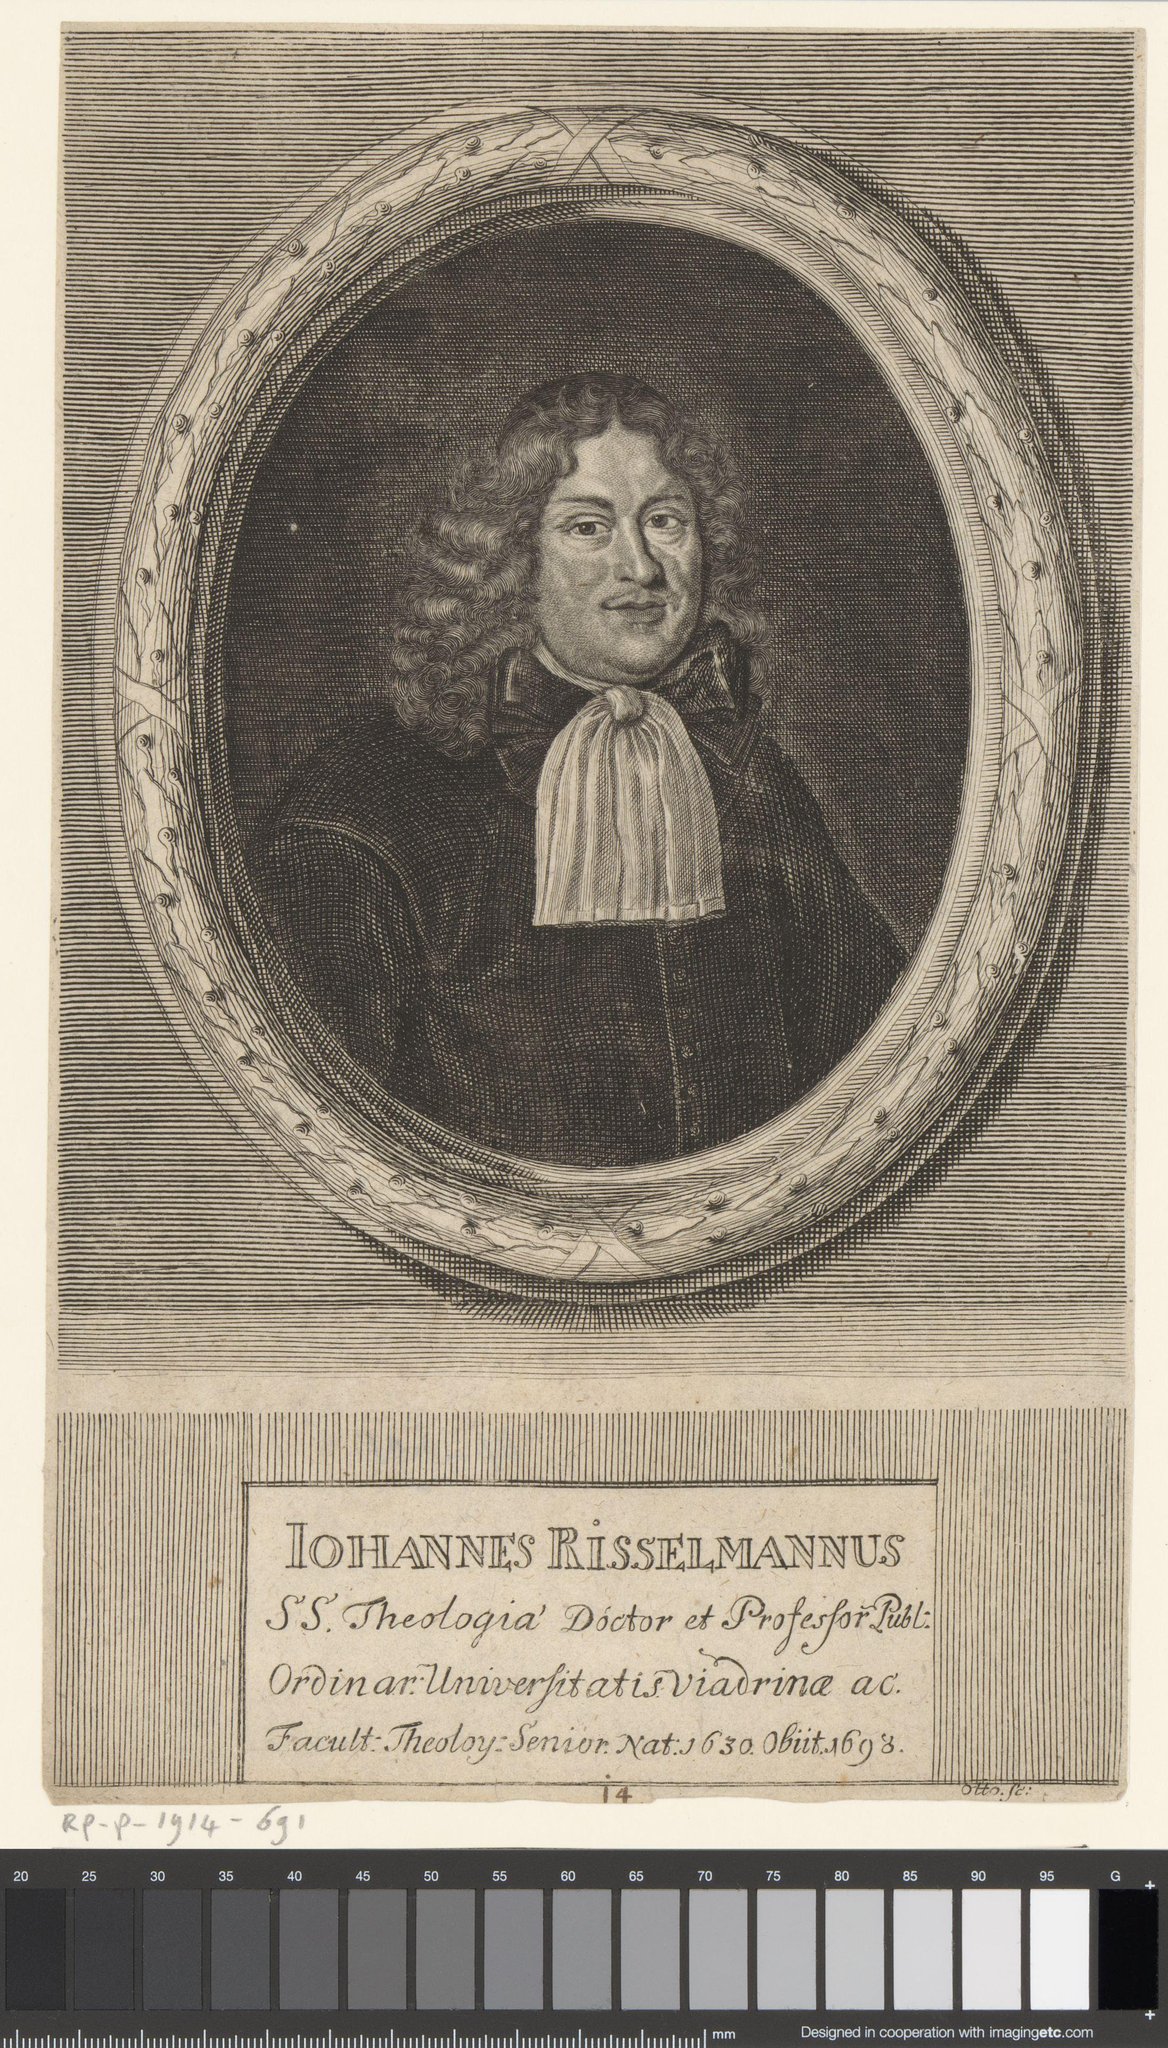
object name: print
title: Portret van Johann Risselmann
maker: heinrich jakob otto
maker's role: print maker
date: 1650-1749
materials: paper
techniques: engraving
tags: historical persons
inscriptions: collector's mark: Lugt 2228, number: ‘14’